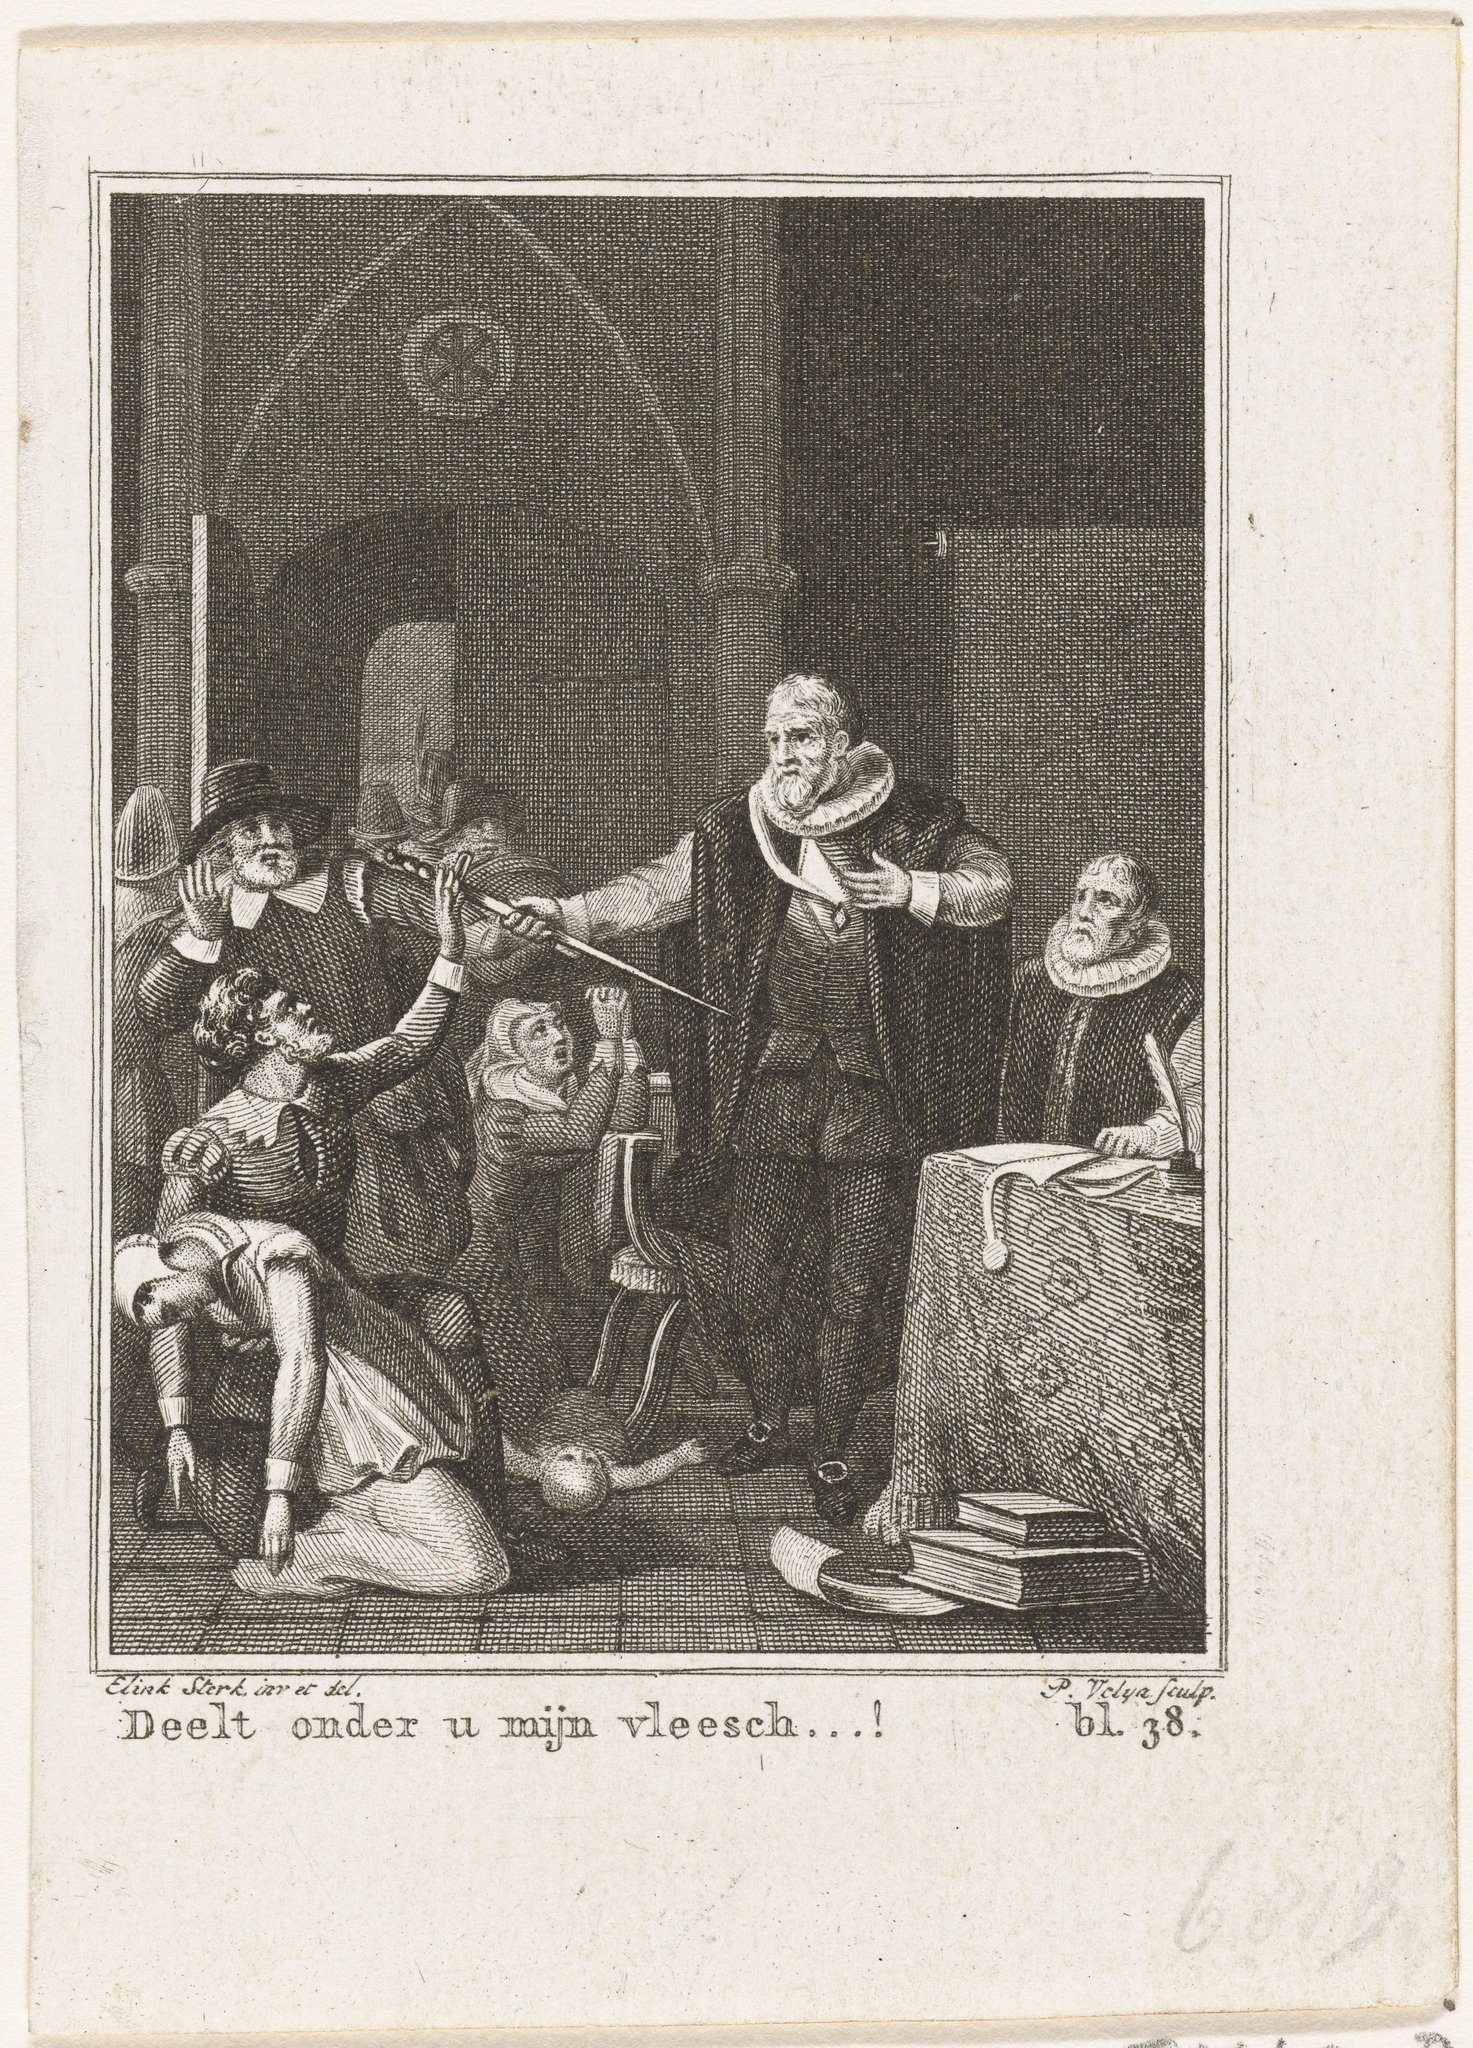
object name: history print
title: De zelfopoffering van burgemeester Pieter van der Werff, 1574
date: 1822-1824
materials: paper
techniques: etching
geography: netherlands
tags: leiden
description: De zelfopoffering van burgemeester Pieter van der Werff, tijdens het beleg van Leiden, 1574. In interieur reikt Van der Werff omstanders zijn zwaard aan.